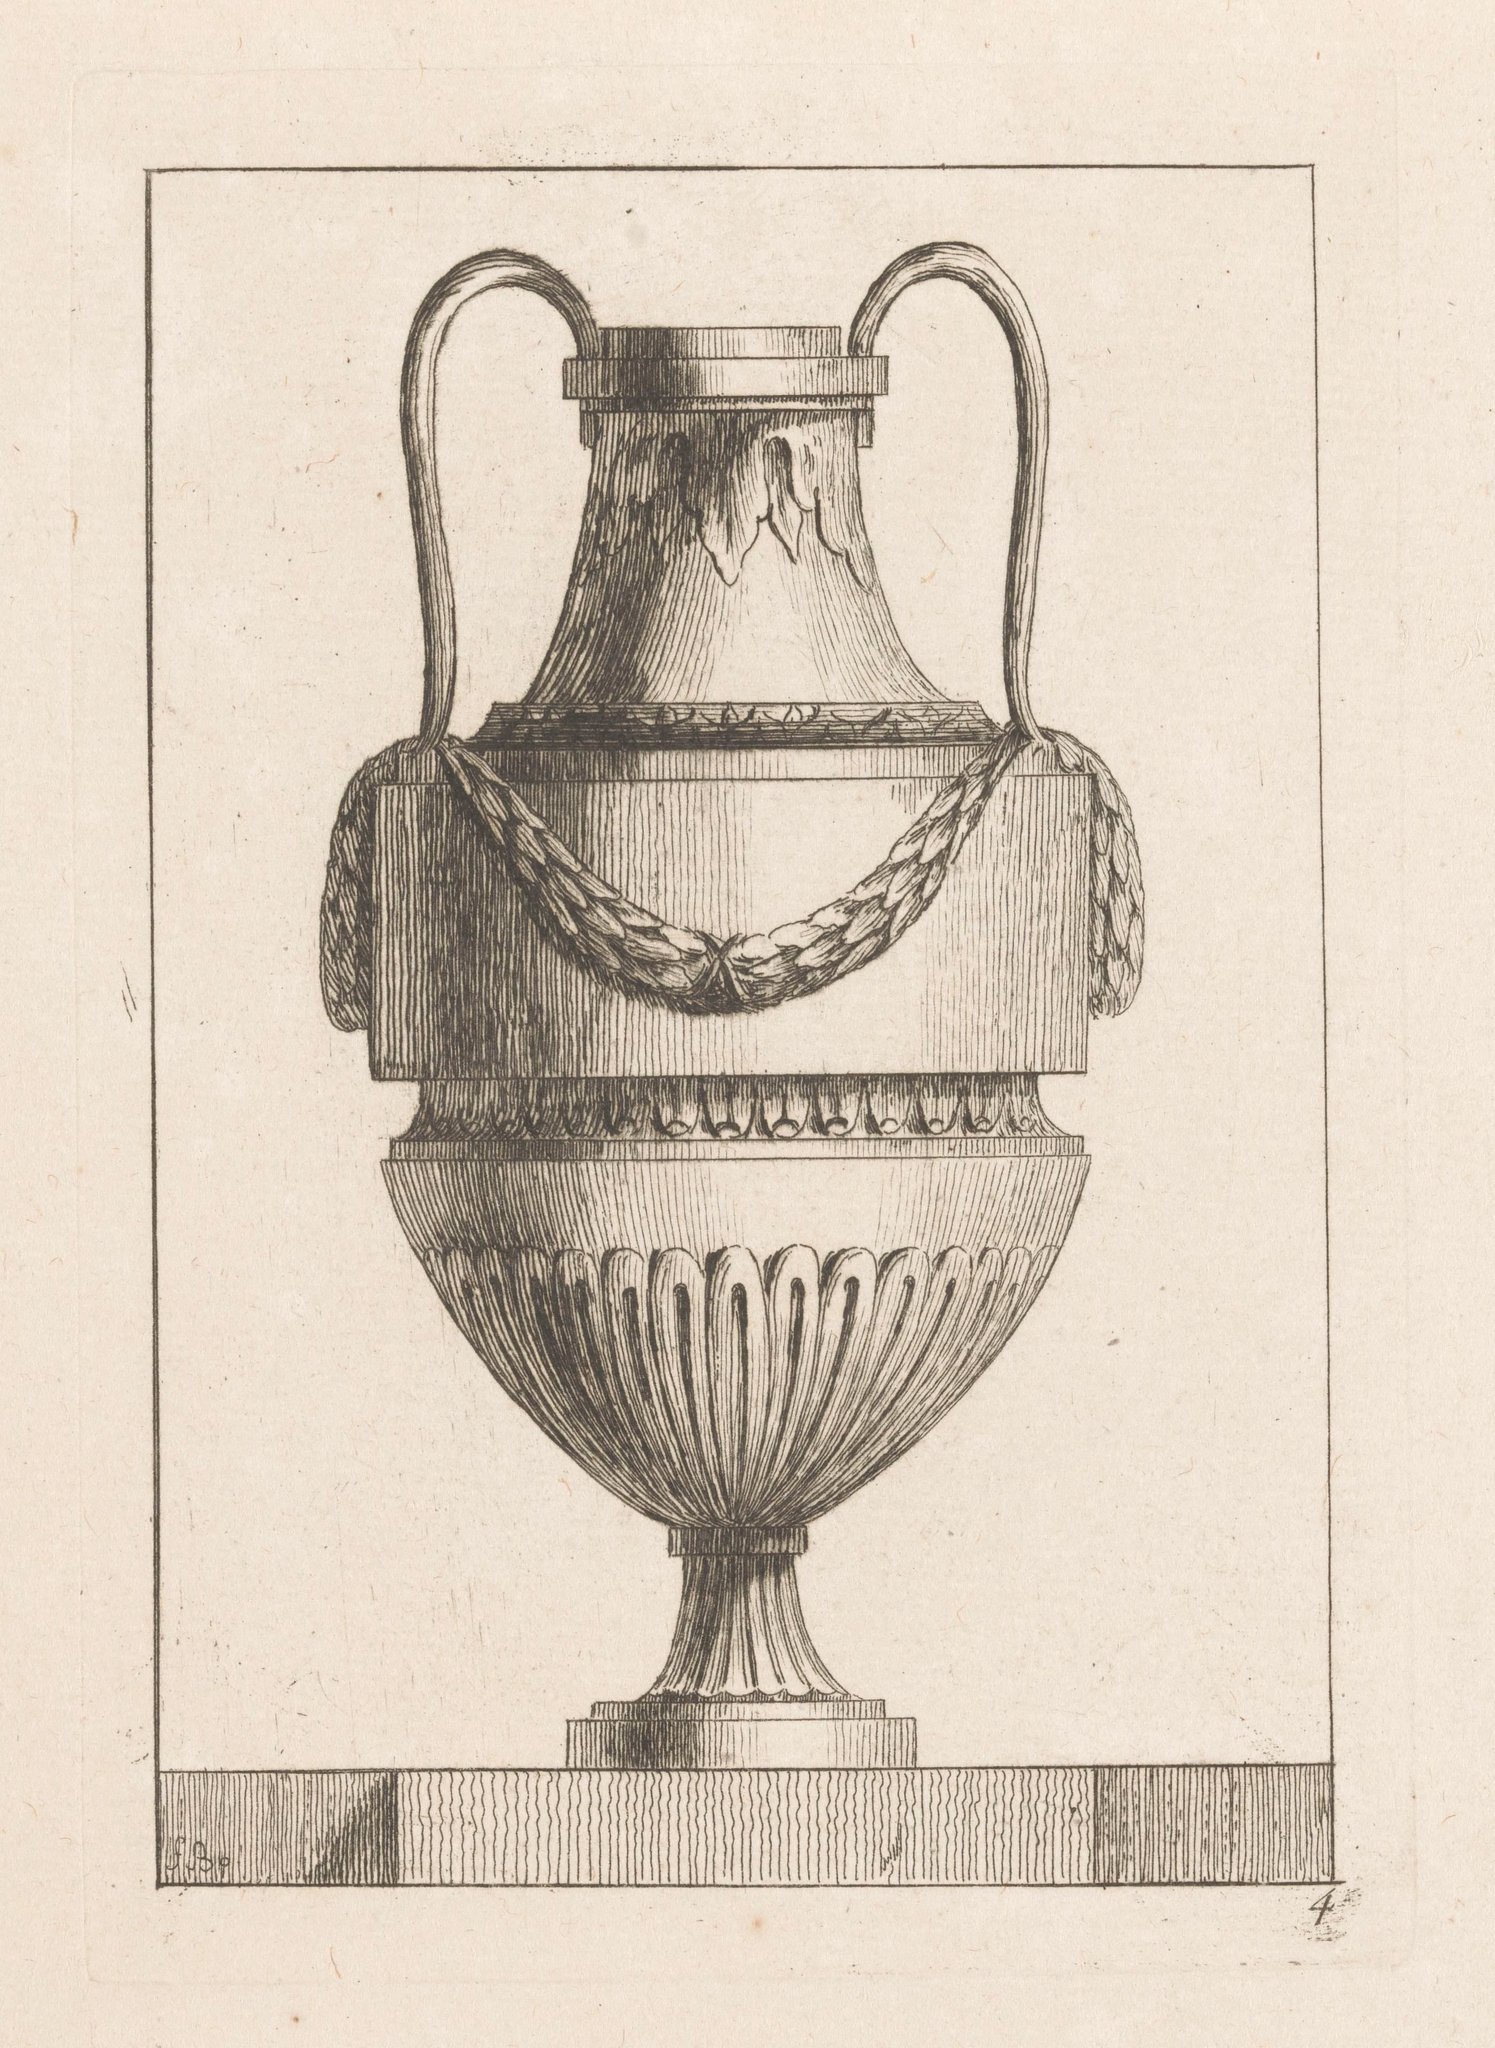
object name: print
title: Vaas met guirlande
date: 1755-1782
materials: paper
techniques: etching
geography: paris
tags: vase ~ ornament, ornament ~ festoon, garland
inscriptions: collector's mark: Lugt 2760, collector's mark: Lugt 2228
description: Een vaas met guirlande over de buik en twee ranke oren.